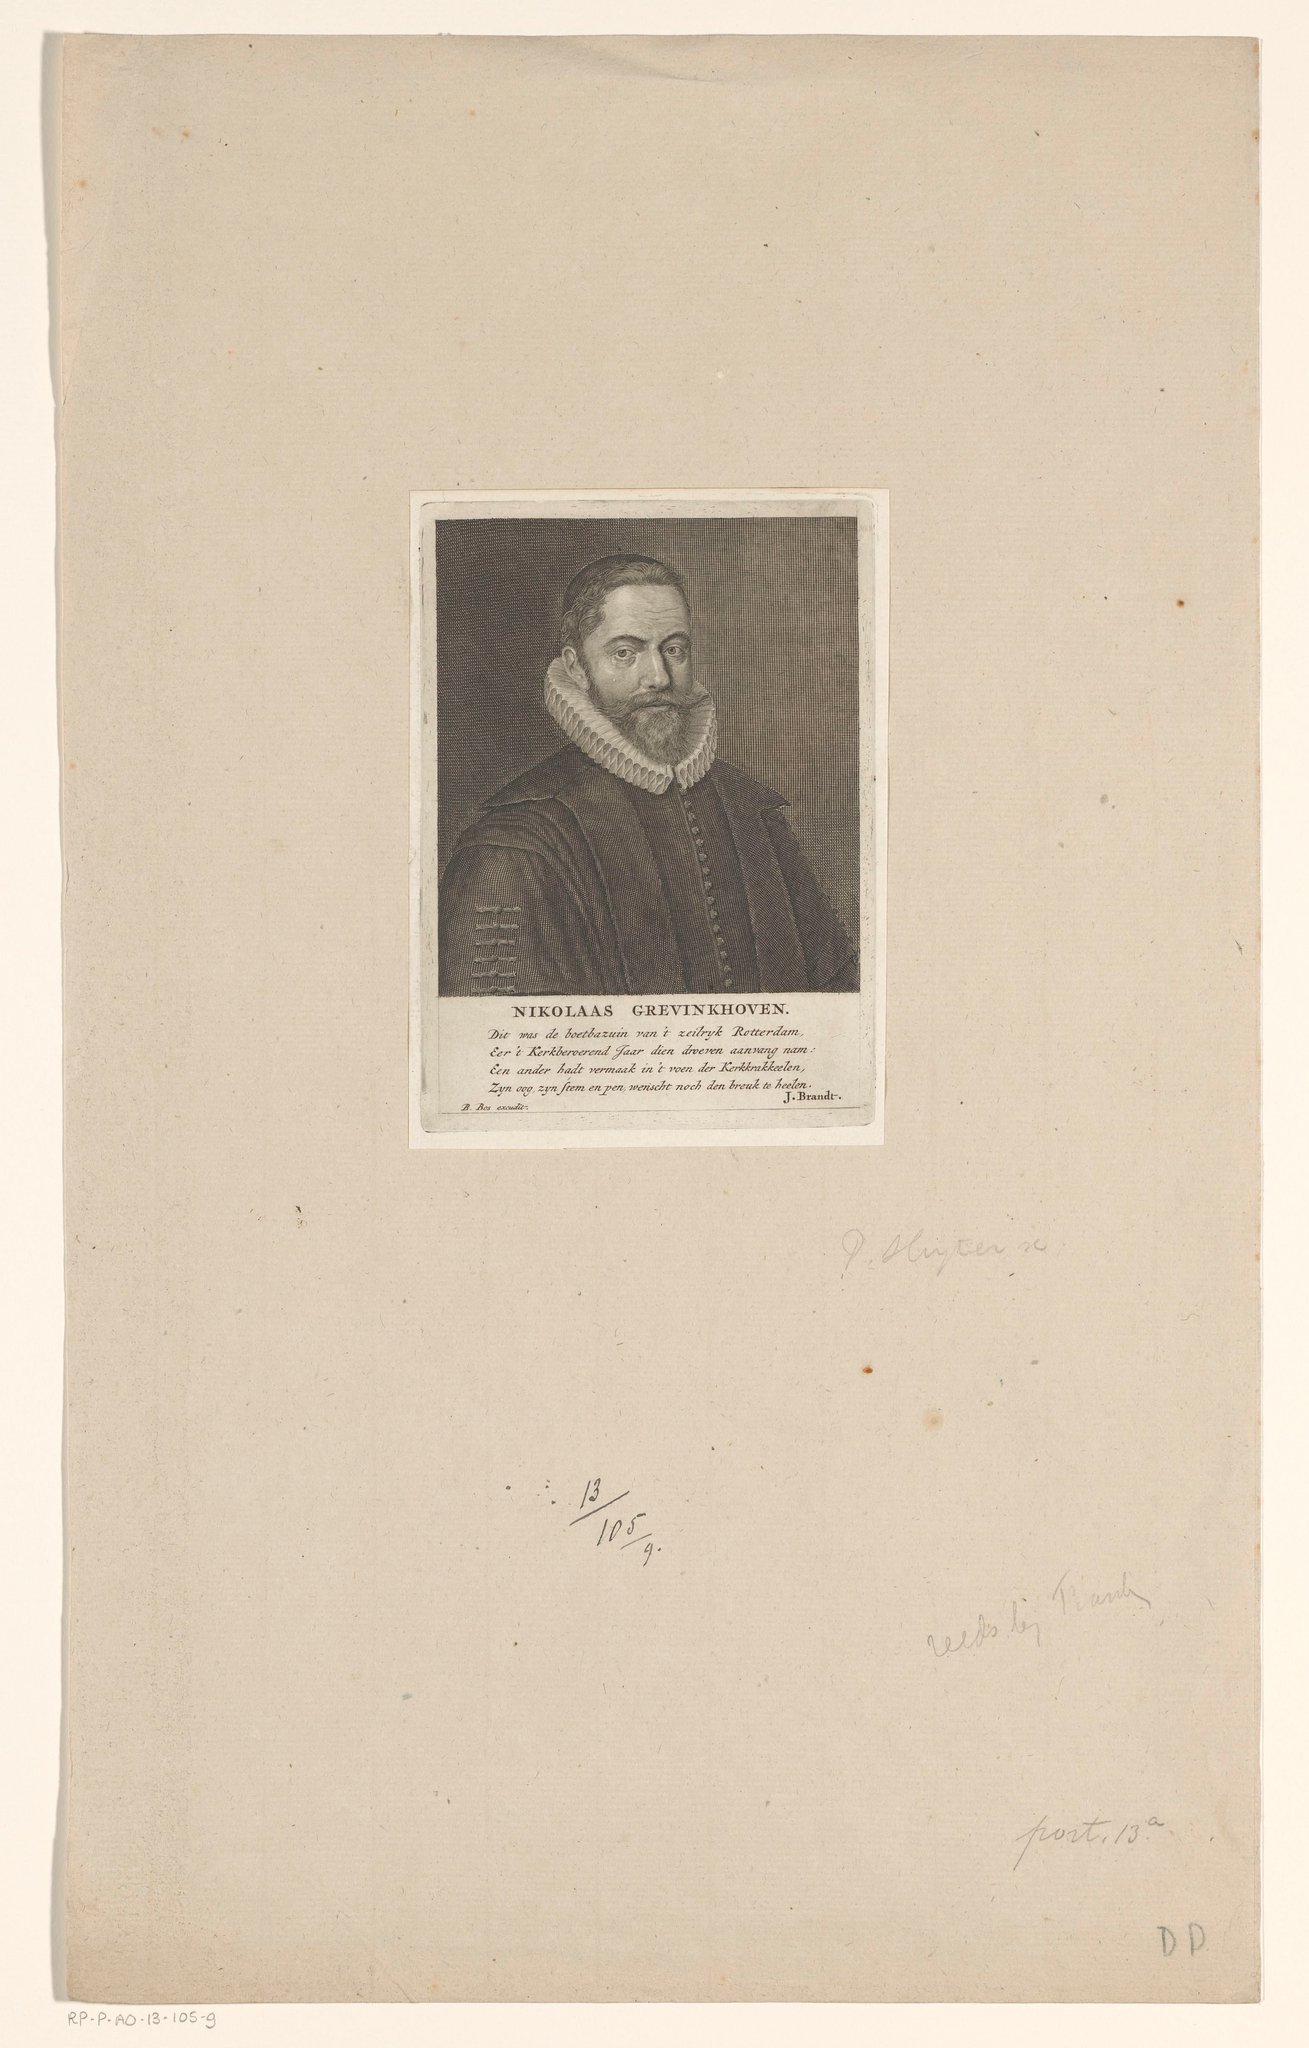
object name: print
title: Portret van Nicolaas Grevinkhoven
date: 1704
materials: paper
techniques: engraving, etching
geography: rotterdam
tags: historical persons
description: Prent ook gebruikt in: G. Brandts Historie der Reformatie, en andre kerkelyke geschiedenissen, in en ontrent de Nederlanden. Het derde deel. Rotterdam: Barent Bos, 1704, tussen p. 748 en 749.